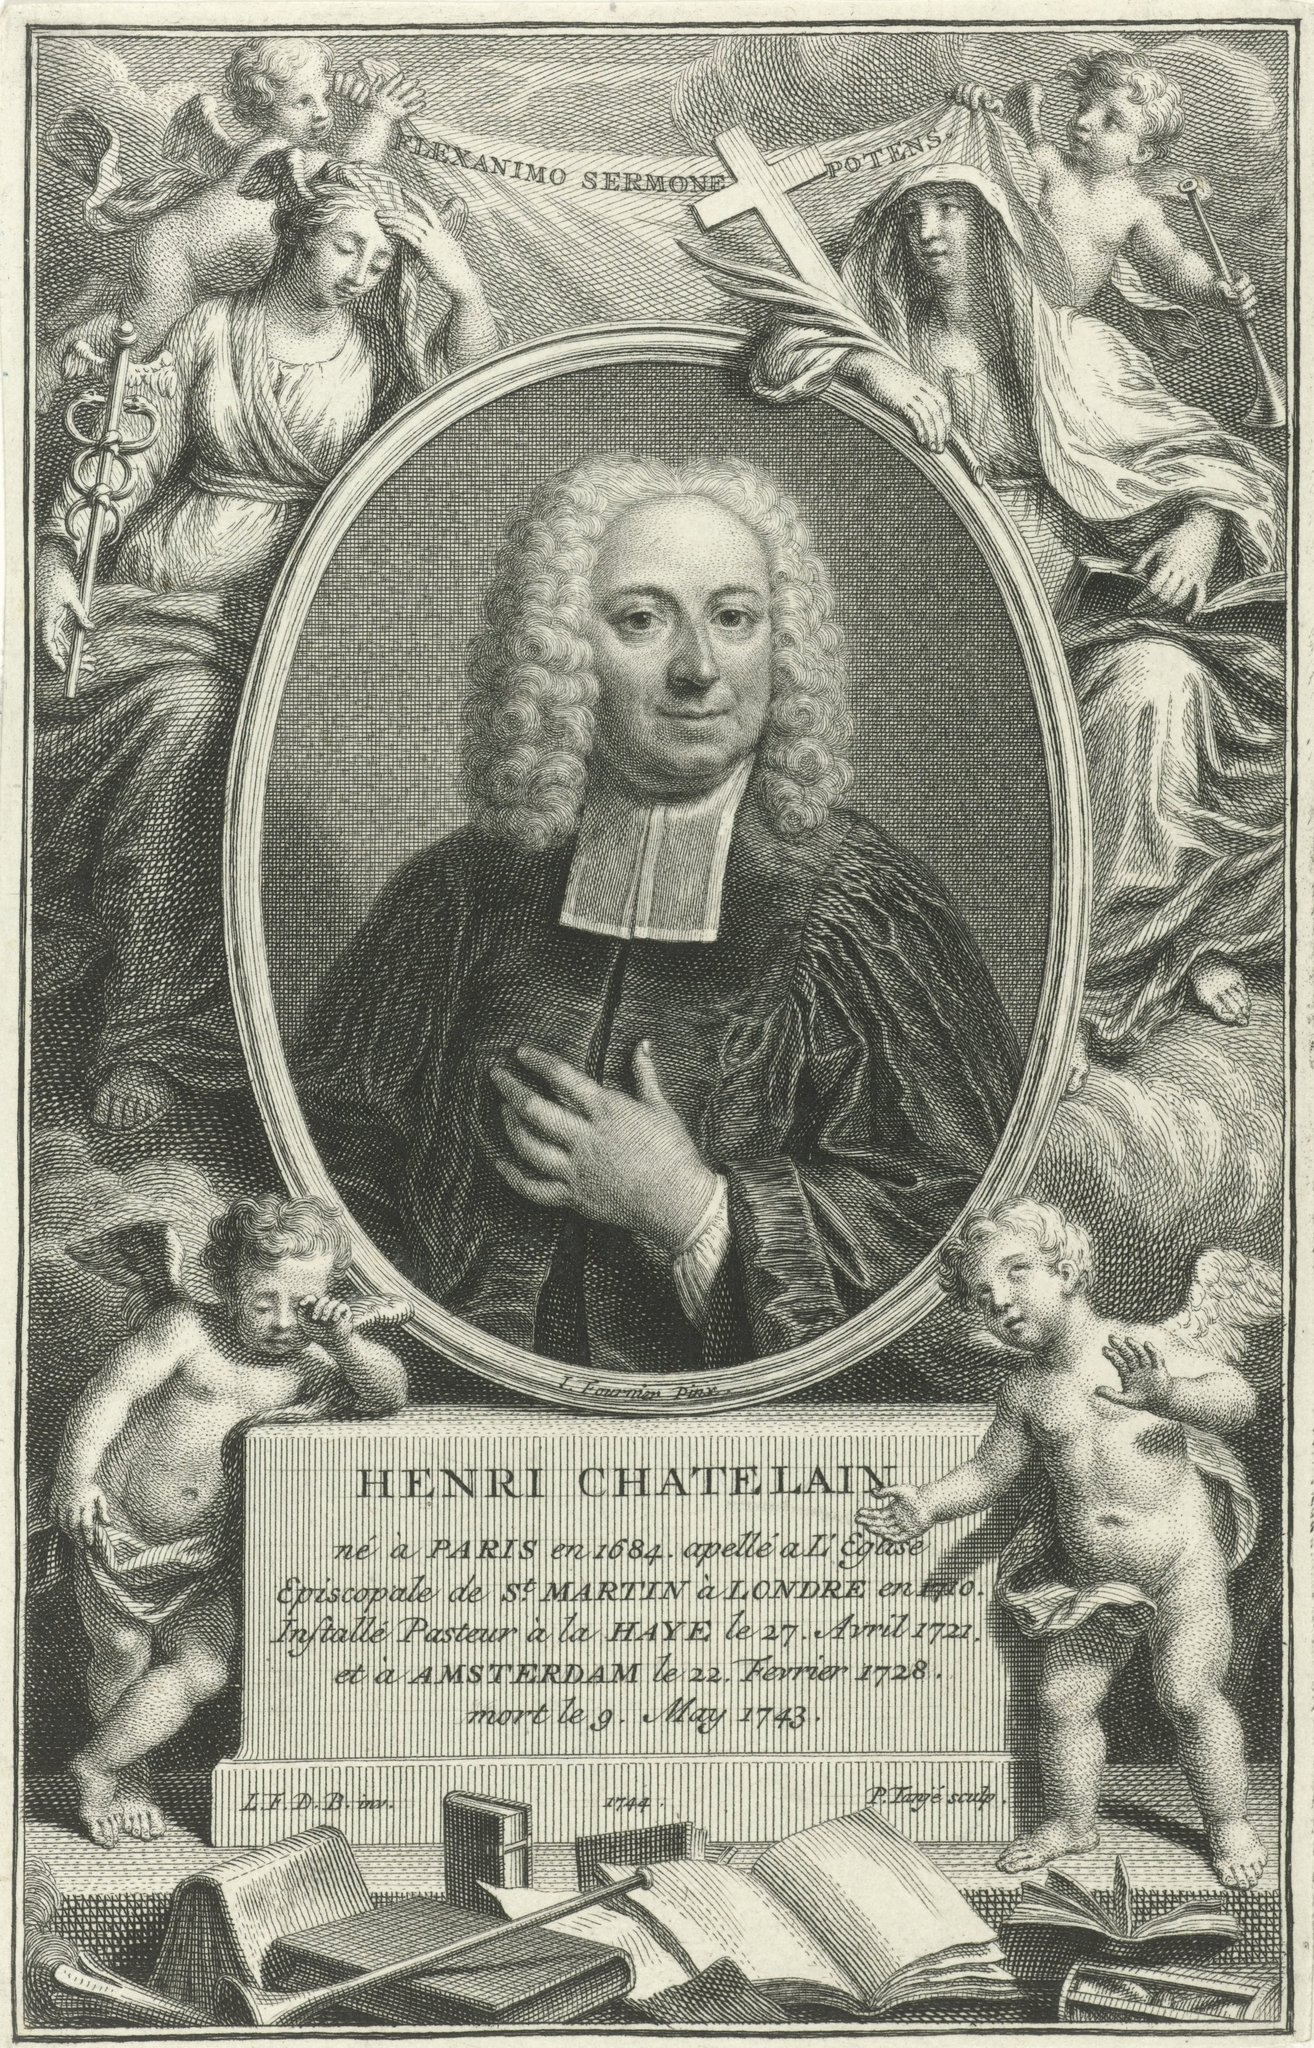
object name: print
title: Portret van Henri Châtelain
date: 1744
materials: paper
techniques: engraving, etching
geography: amsterdam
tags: paris, faith, 'fides'; 'fede', 'fede catholica', 'fede christiana', 'fede christiana catholica' (ripa) ~ one of the three theological virtues, symbols, allegories of peace, 'pax'; 'pace' (ripa), cupids: 'amores', 'amoretti', 'putti'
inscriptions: collector's mark: Lugt 2228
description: Portret van Henri Châtelain, predikant van de Waalse Kerk te Den Haag en Amsterdam. Het portret wordt omgeven door allegorische figuren. Boven flankeren de Vrede, met caduceus en petasus, en het Geloof, met kruis, de lijst. Bij het piedestal een treurende putto en een putto, die op boeken, een gedoofde toorts en een zandloper wijst.